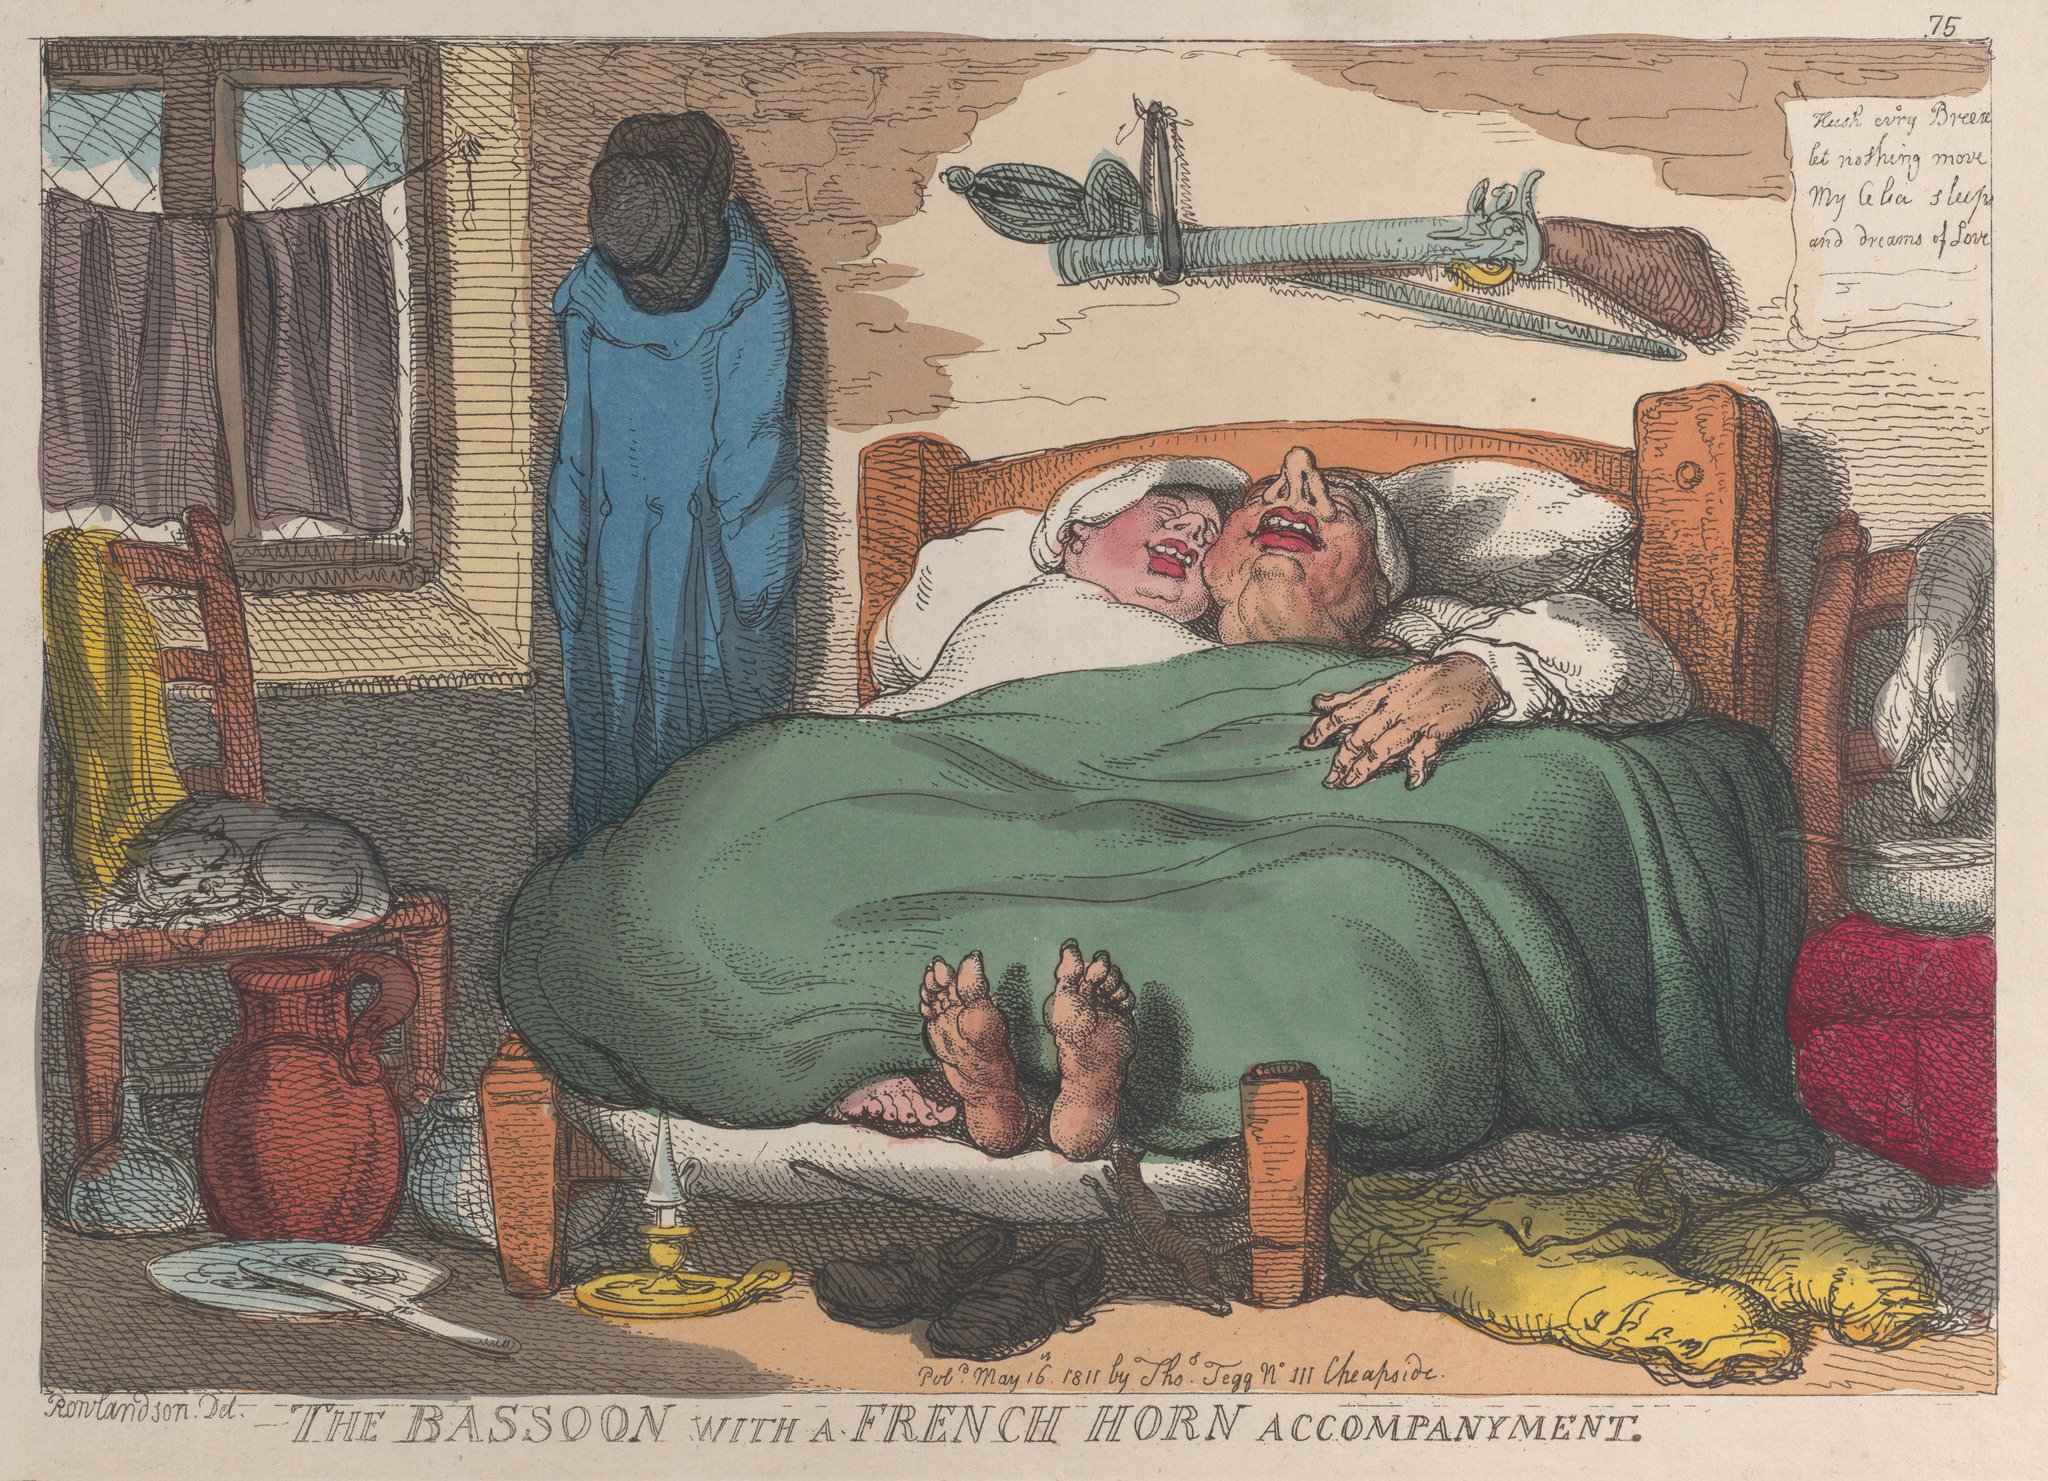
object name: print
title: The Bassoon with a French Horn Accompaniment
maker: thomas rowlandson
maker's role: artist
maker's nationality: british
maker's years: 1757-1827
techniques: etching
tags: satire,bedrooms,sleeping,men,women,cats,caricature